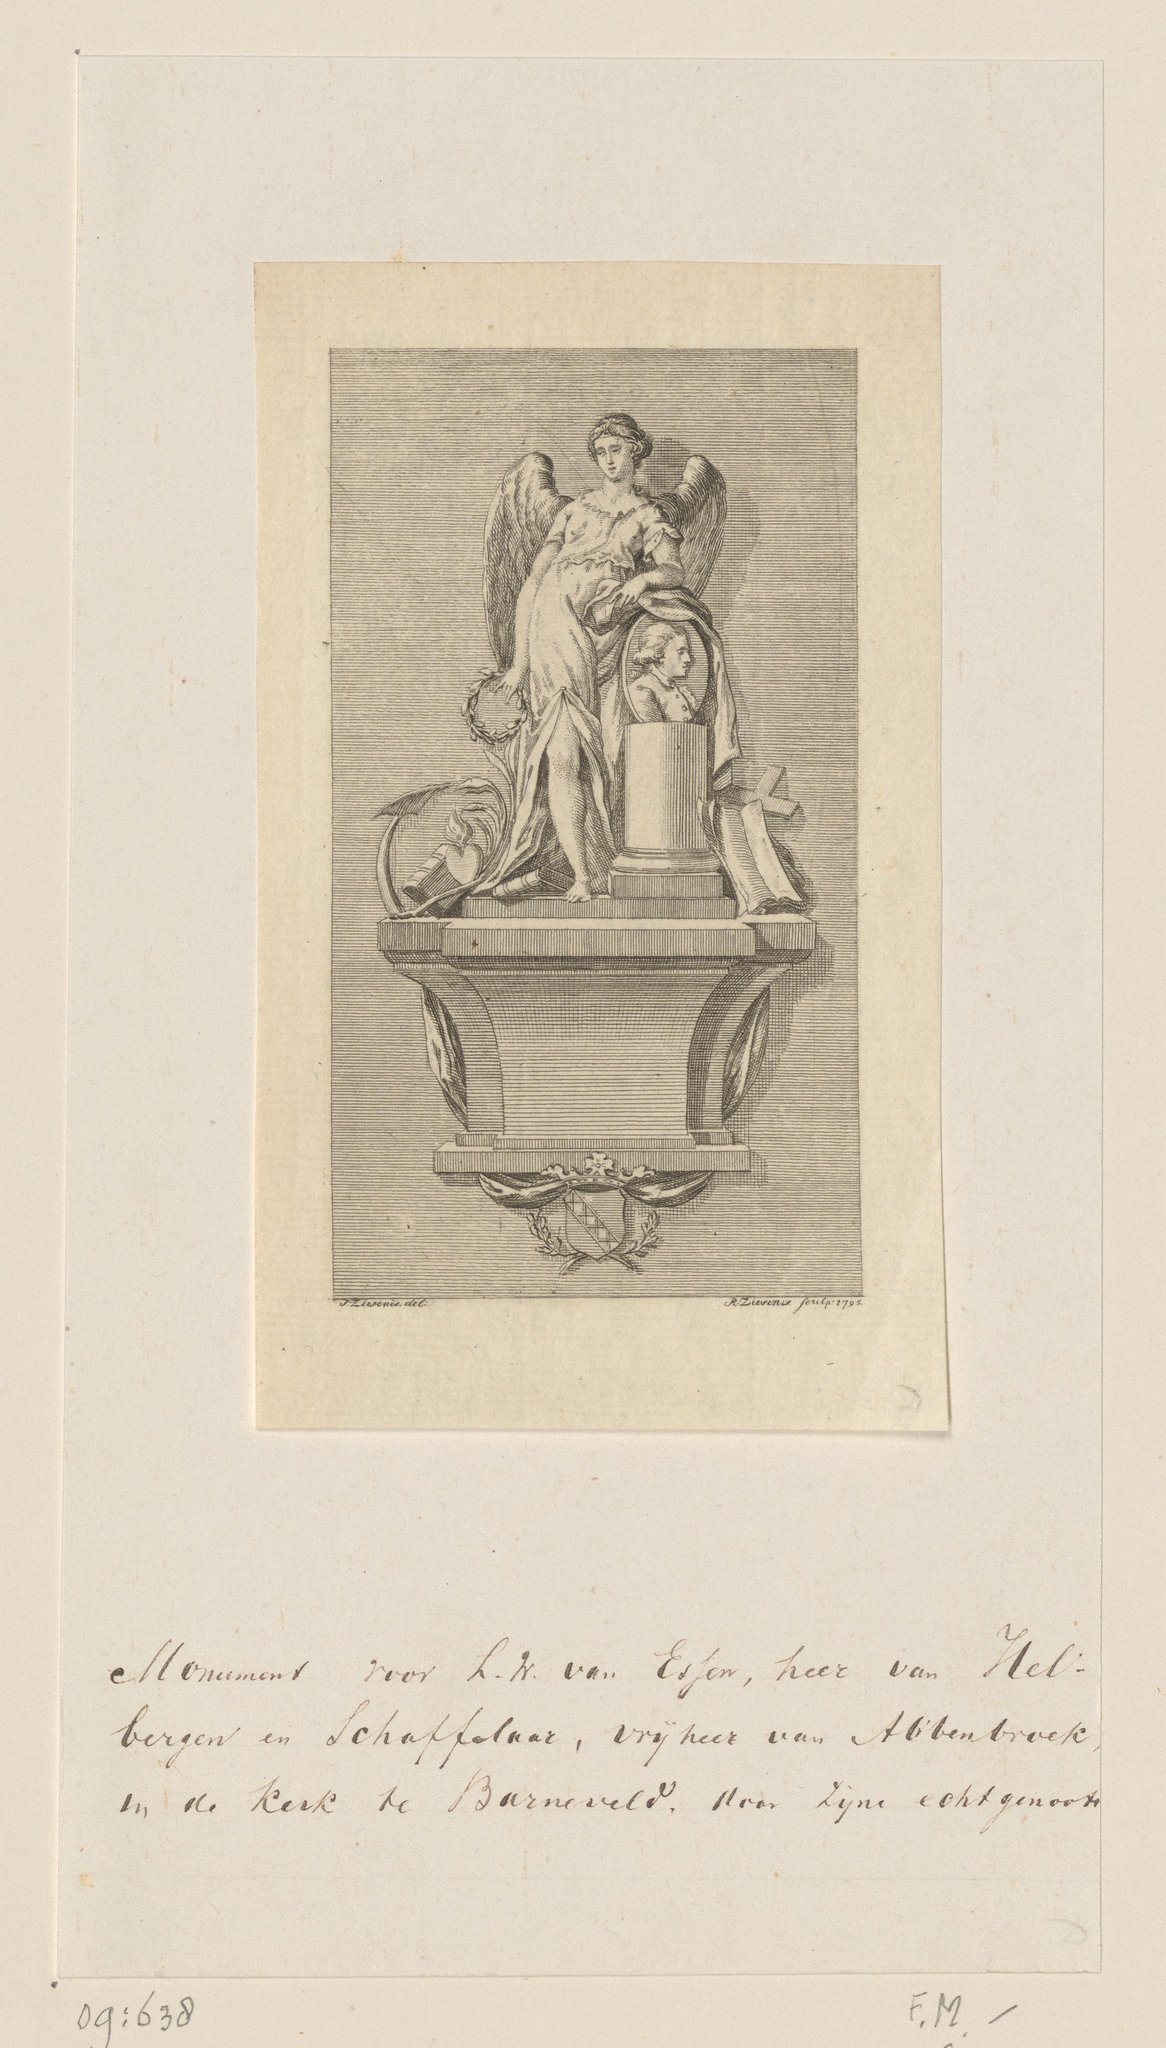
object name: print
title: Gedenkteken voor Lukas Willem baron van Essen te Barneveld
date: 1795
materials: paper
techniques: etching, snipping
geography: netherlands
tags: the three theological virtues, victoria as roman personification, historical persons, other memorial structures, armorial bearing, heraldry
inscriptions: inscription: ‘Monument voor L.W. van Essen, heer van Hel/ berg en Schaffelaar, vrijheer van Abbenbroek,/ in de Kerk te Barneveld. Voor Zijne echtgenoote’, collector's mark: Lugt 2228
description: Gedenkteken voor Lukas Willem baron van Essen in de Oude kerk van Barneveld. Victoria, de godin van de overwinning houdt een lauwerkrans in de hand en leunt met haar andere arm op het portret van baron van Essen. Aan haar voeten liggen een kruis, anker en een brandend hart, de symbolen voor geloof, hoop en liefde, en een Bijbel. Midden onder het wapenschild van baron van Essen.